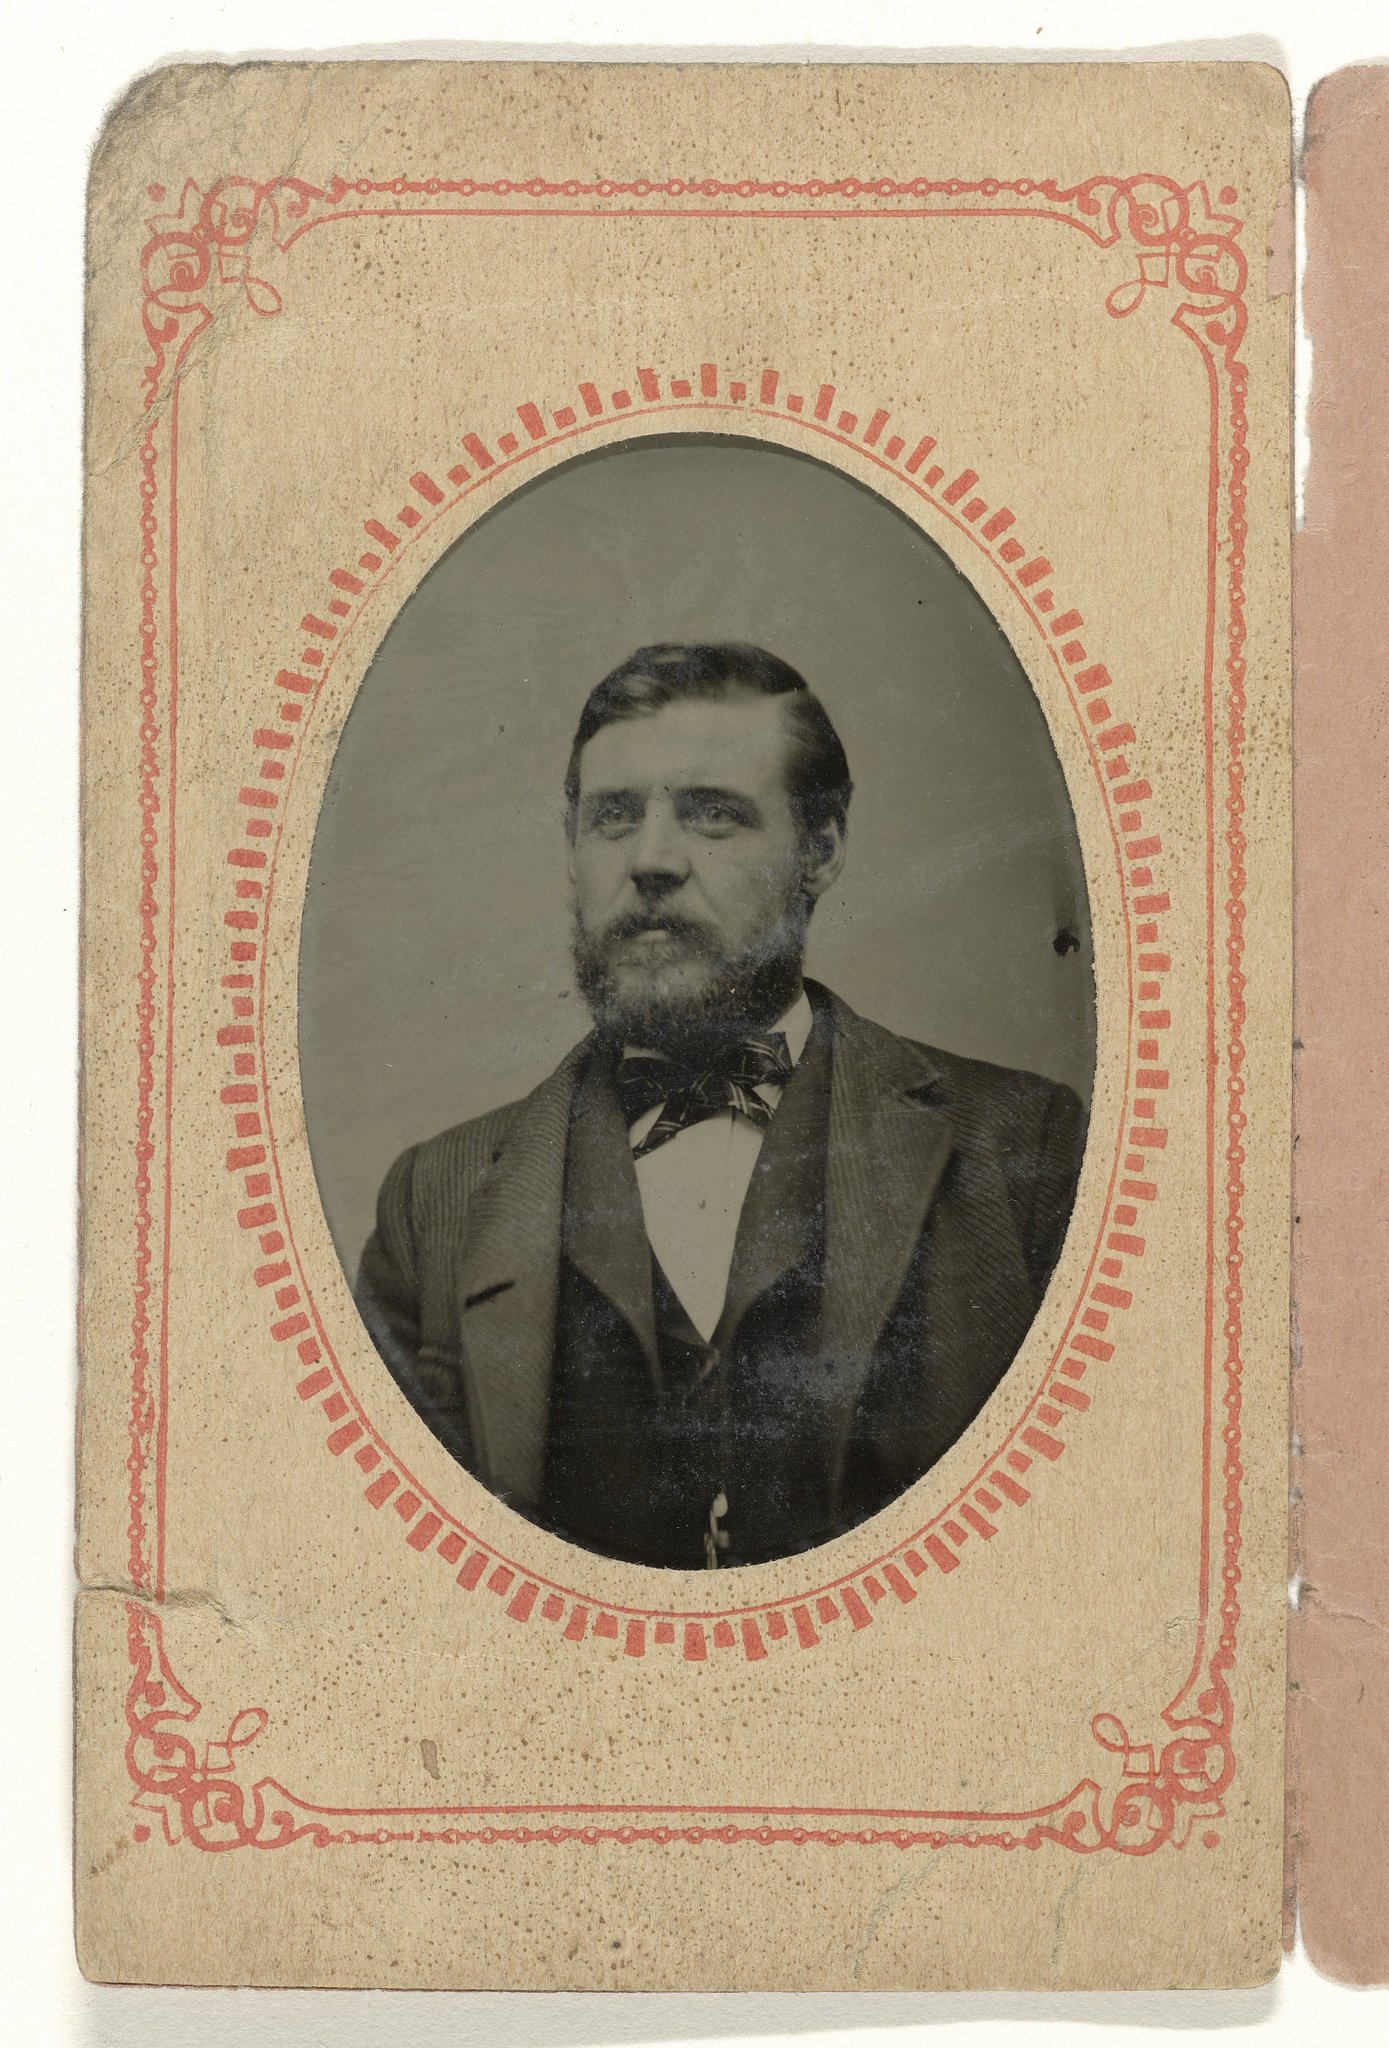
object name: photograph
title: Portret van een man, Verenigde Staten, in een papieren passepartout met een reclametekst voor kleding (Jackson's Home-Made Suits, Pittsburgh, PA)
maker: Anonymous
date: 1880-1910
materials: metal, paper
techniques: ferrotyping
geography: united states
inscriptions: inscription: ‘HOW MUCH BETTER YOU'D / LOOK IN ONE OF / JACKSONS / Home - Made Suits. / BEST GOODS. / LOWEST PRICES. / 954 - 956 Liberty Street, / STAR CORNER. / PITTSBURGH PA. // Best Hats, / Best Furnishings, / CLOTHING, / READY-MADE OR MADE TO ORDER, / JACKSON'S, / 954 & 956 LIBERTY STREET. / STAR CORNER.’